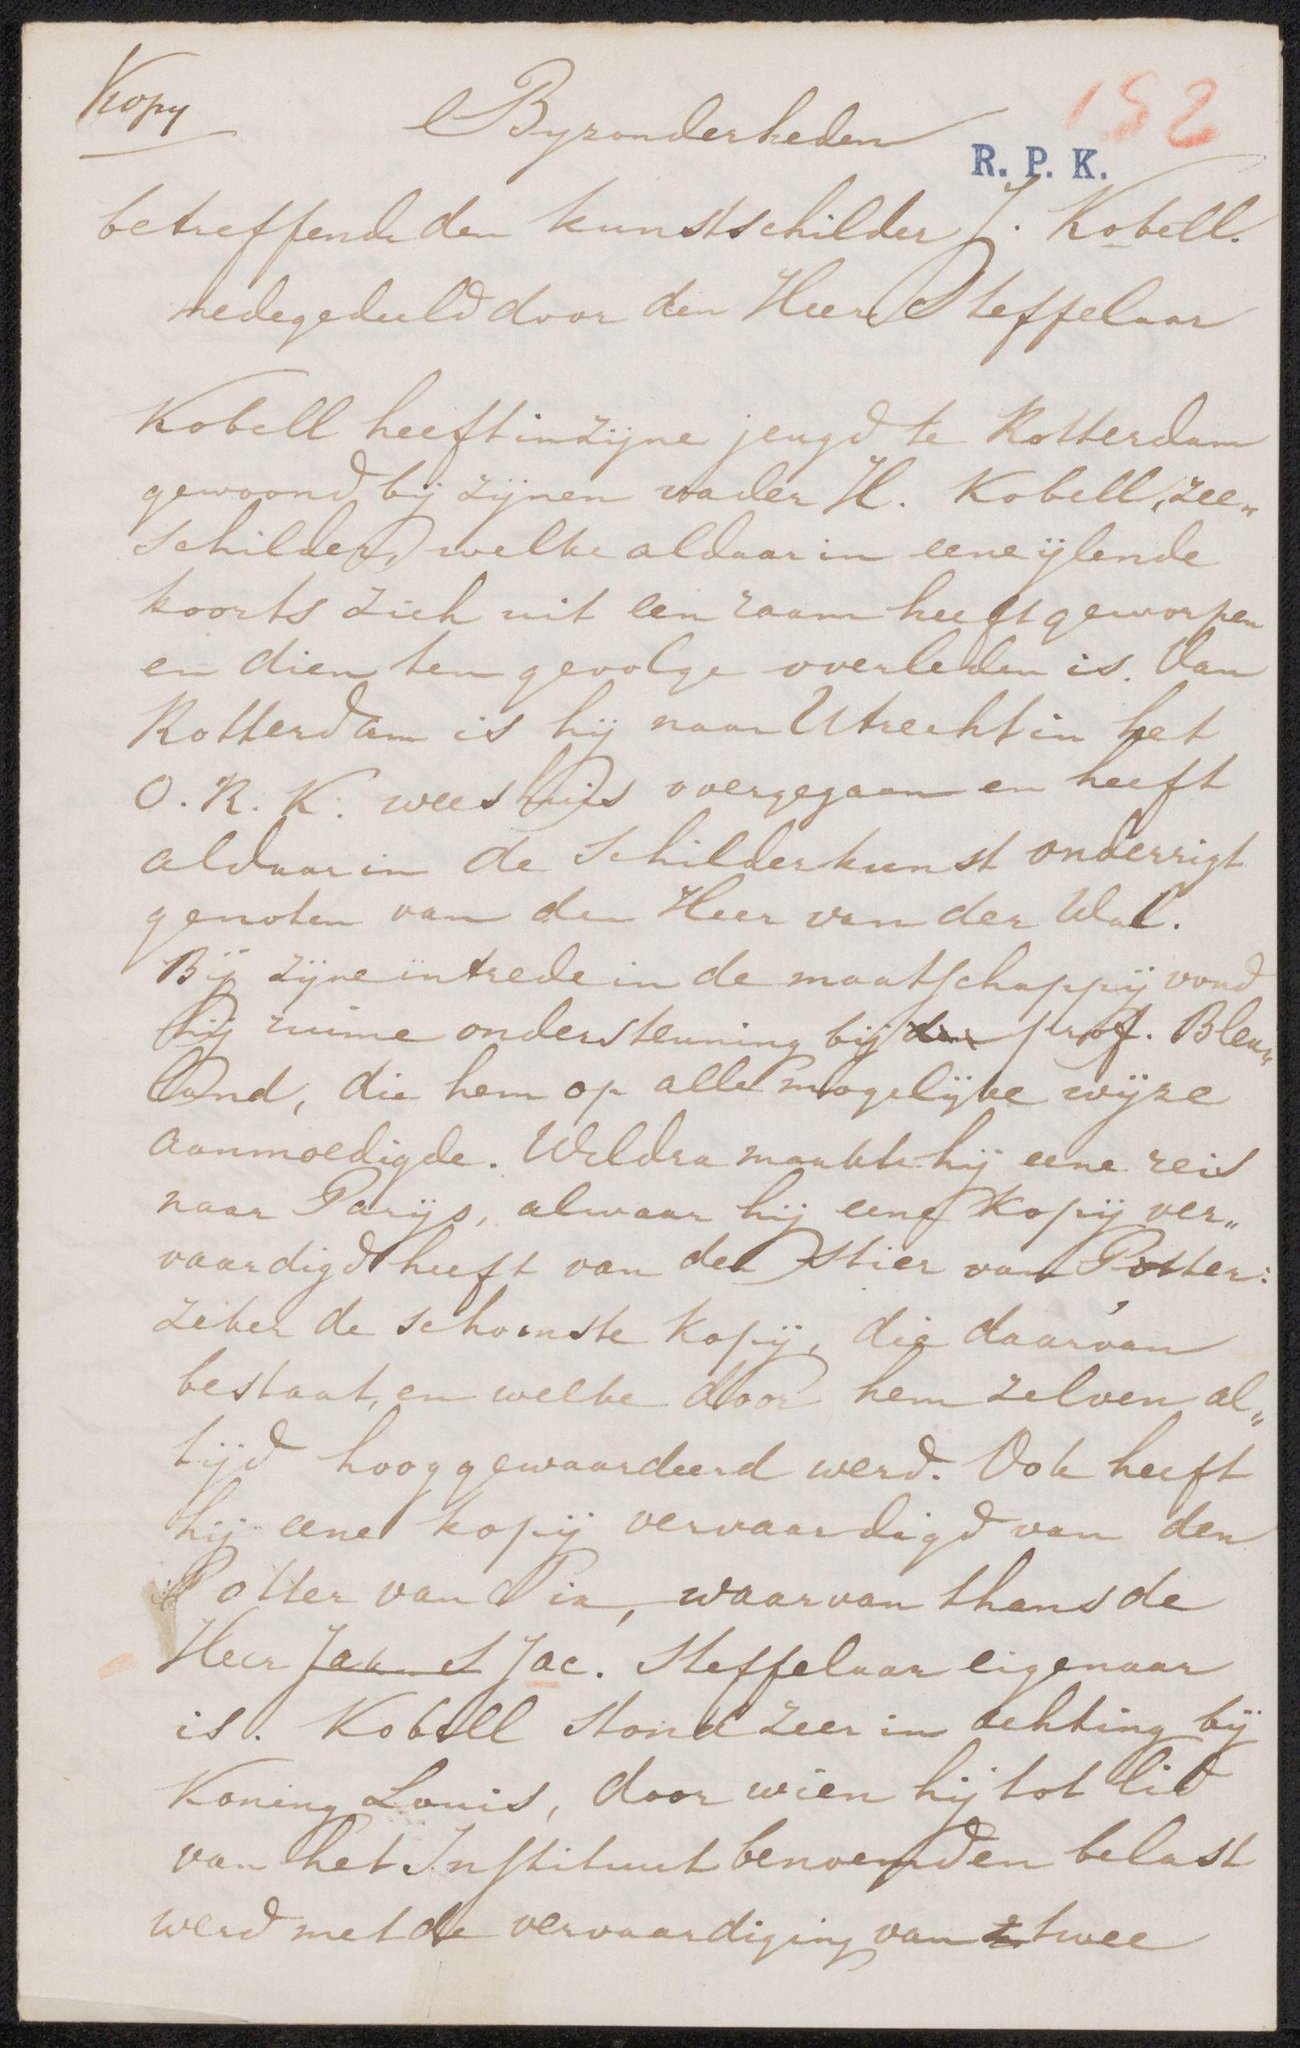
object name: letter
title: Brief aan Christiaan Kramm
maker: cornelis steffelaar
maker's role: draughtsman, painter, print maker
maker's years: 1797-1861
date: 1814-1861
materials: ink, paper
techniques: pen, writing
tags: delfshaven, jan kobell (ii), utrecht, christiaan kramm, education, tuition of the artist (in general), painting (including book-illumination, miniature-painting), historical persons (portraits and scenes from the life)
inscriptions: collector's mark: Lugt 2233